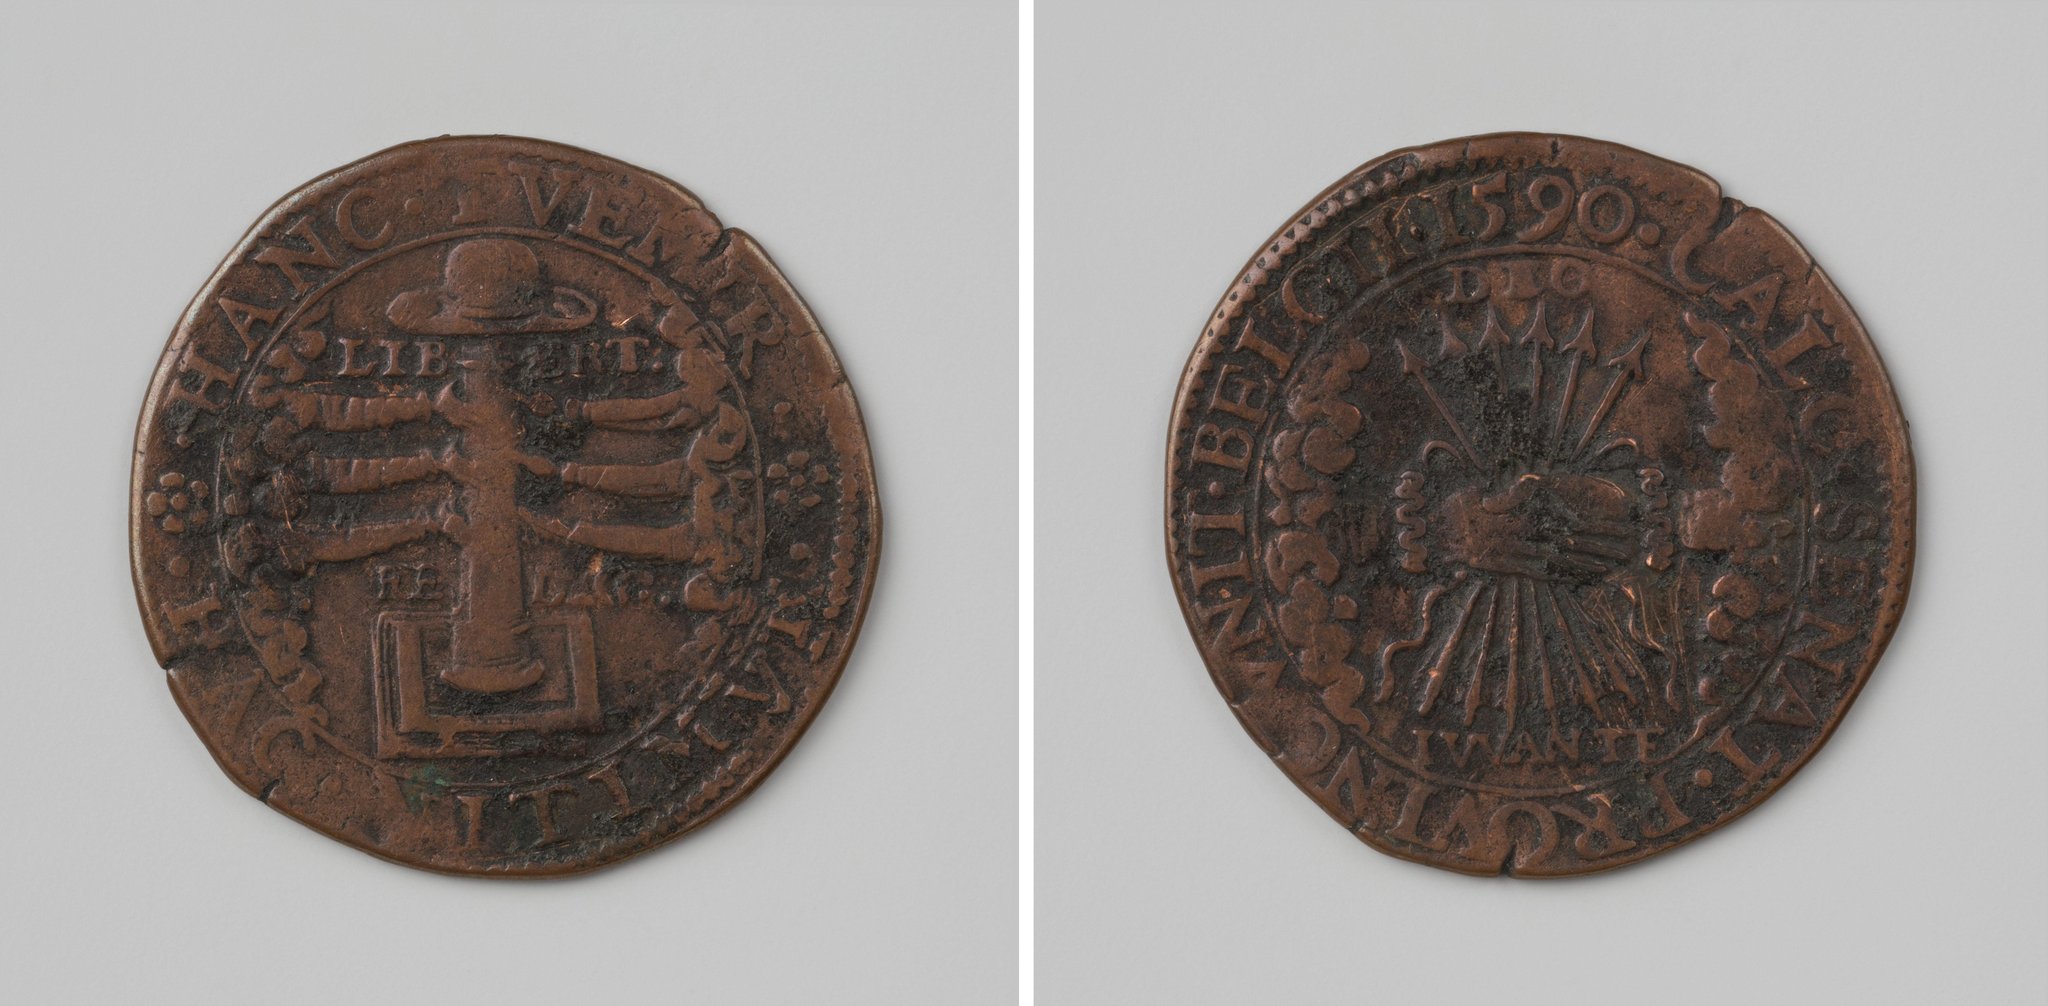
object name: jeton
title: Verkiezing van Maurits, graaf van Nassau gekozen tot stadhouder van alle opstandige gewesten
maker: Anonymous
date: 1590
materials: copper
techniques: striking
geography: dordrecht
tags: the hague, maurice (prince of orange)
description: Koperen penning. Voorzijde: zes handen uit wolken houden gezamelijk een zuil vast, die op een bijbel rust en door een vrijheidshoed bekroond wordt; onder vrijheidshoed en boven bijbel: opschriften binnen omschrift. Keerzijde: twee ineen geslagen handen houden samen bundel van zes pijlen vast tussen opschriften binnen omschrift